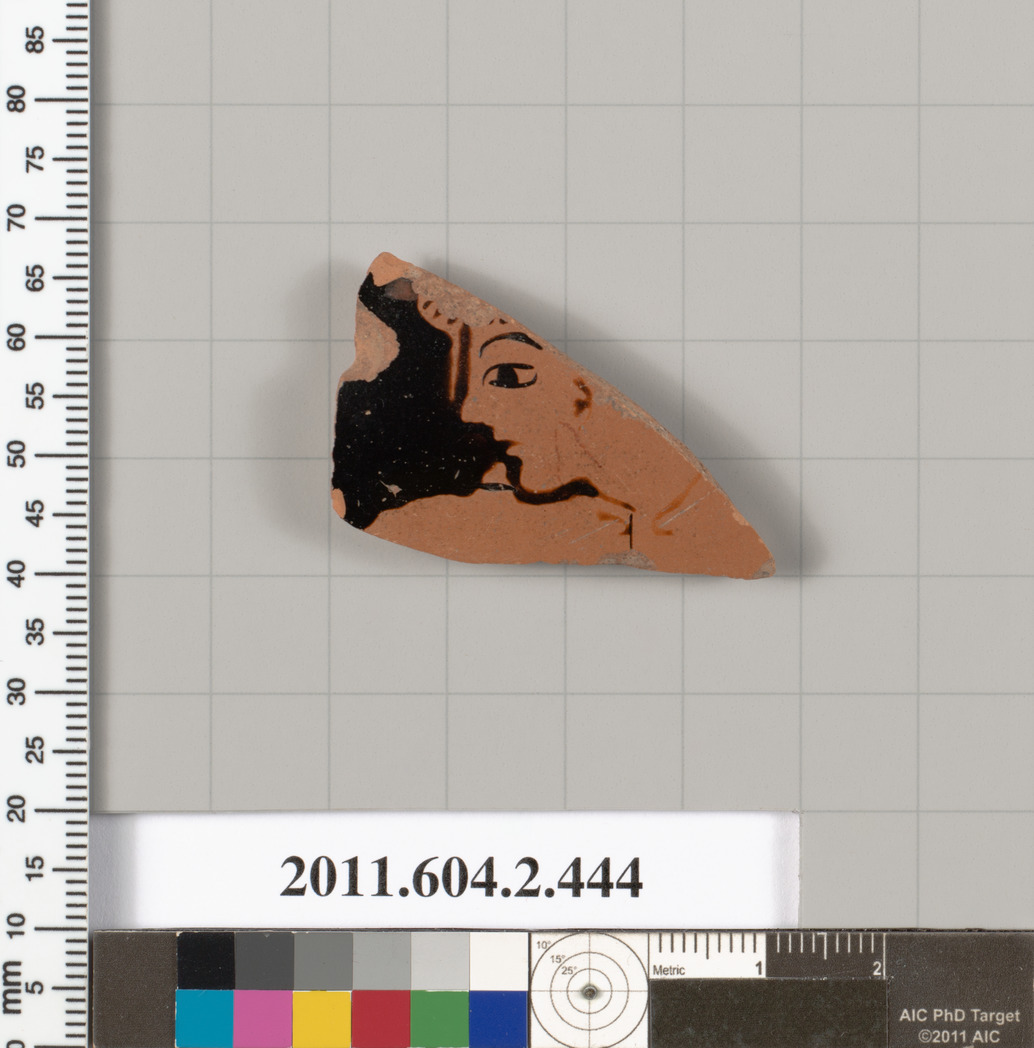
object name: column krater fragment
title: Terracotta fragment of a column-krater (bowl for mixing wine and water)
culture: greek, attic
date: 475-451 BCE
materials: terracotta